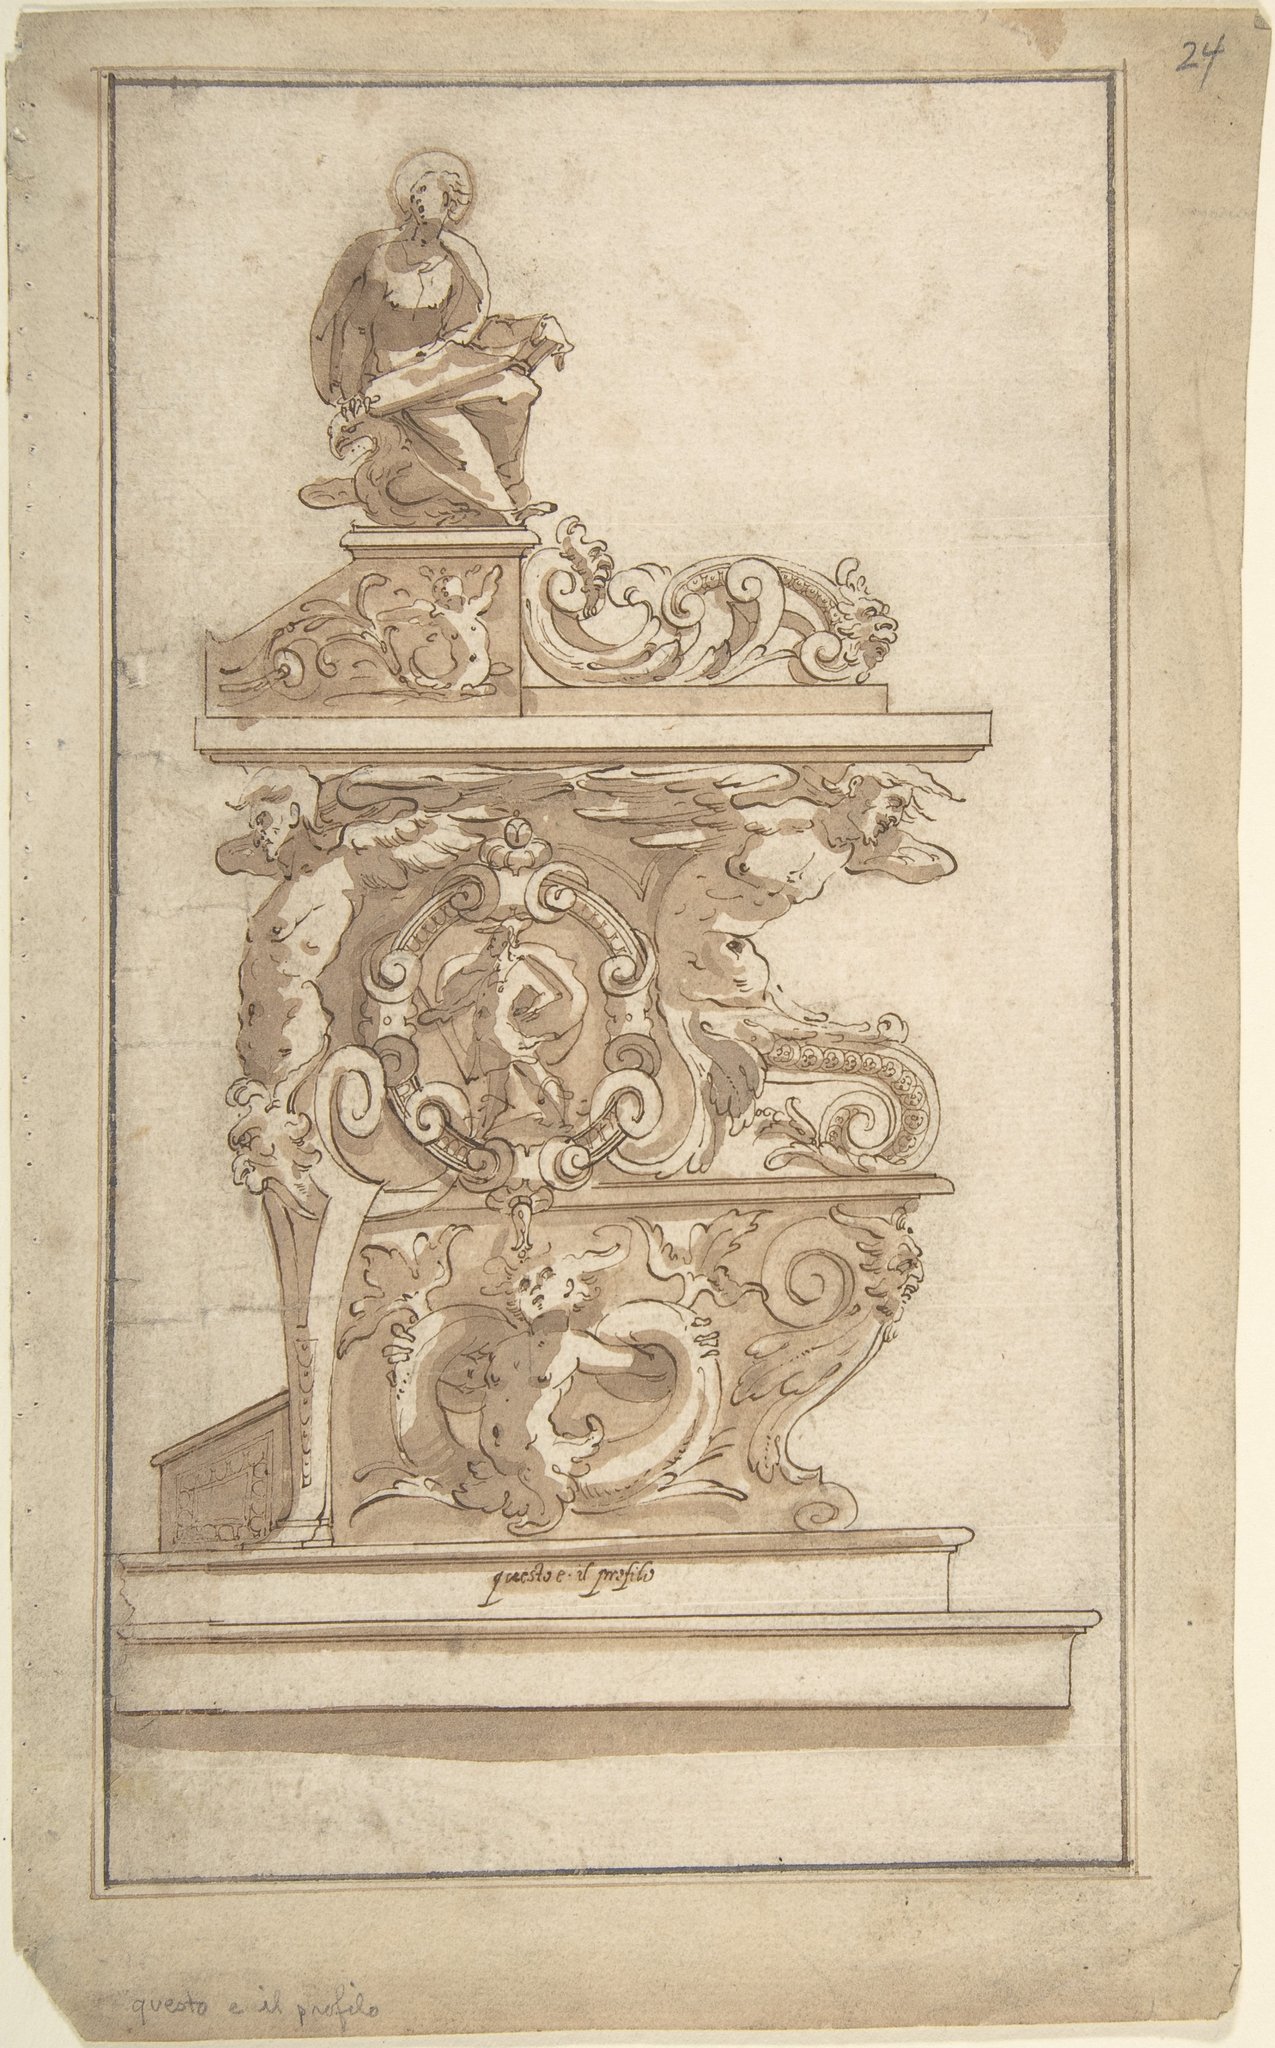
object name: drawing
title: Design for a Lectern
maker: anonymous, italian, 16th century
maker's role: artist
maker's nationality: italian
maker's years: 1500-1600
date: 1501-1600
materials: ink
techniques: brush, pen, wash